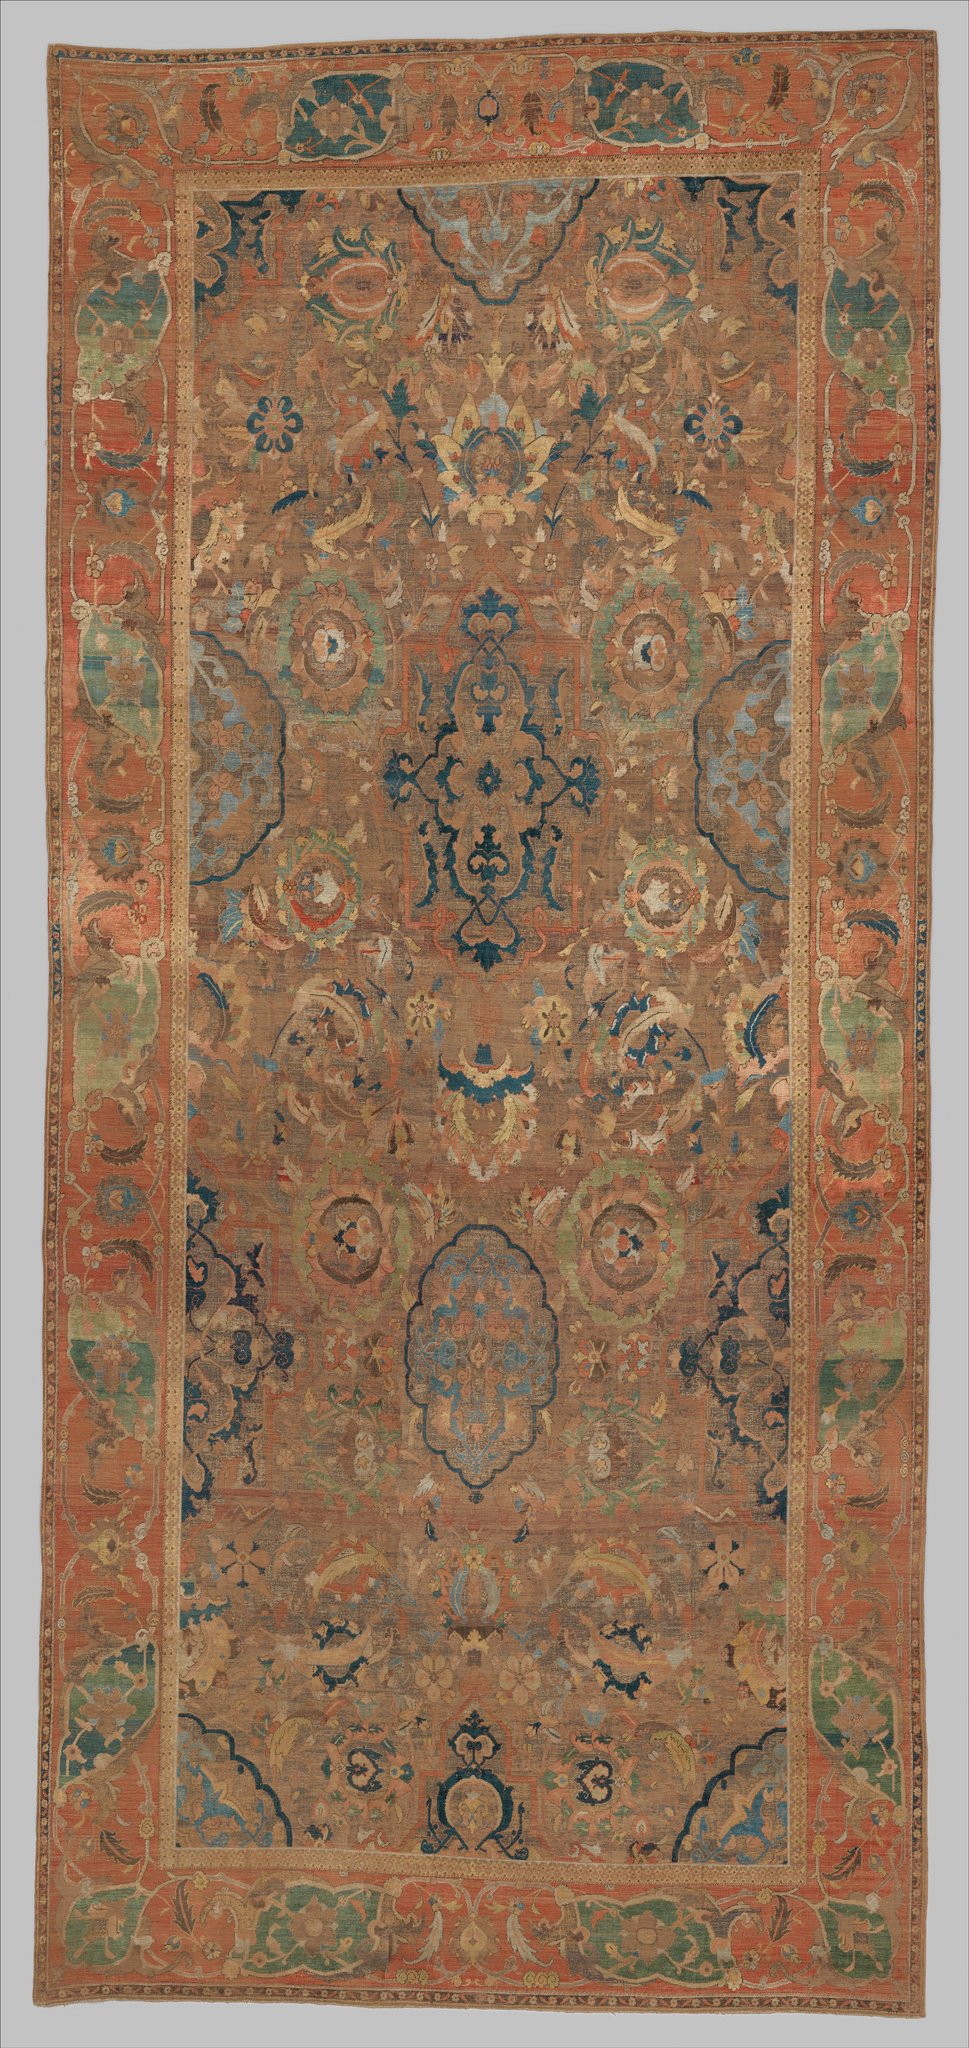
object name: carpet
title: The "Doria" Carpet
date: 1601-1700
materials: metal thread, silk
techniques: asymmetrically knotted pile, brocade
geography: iran